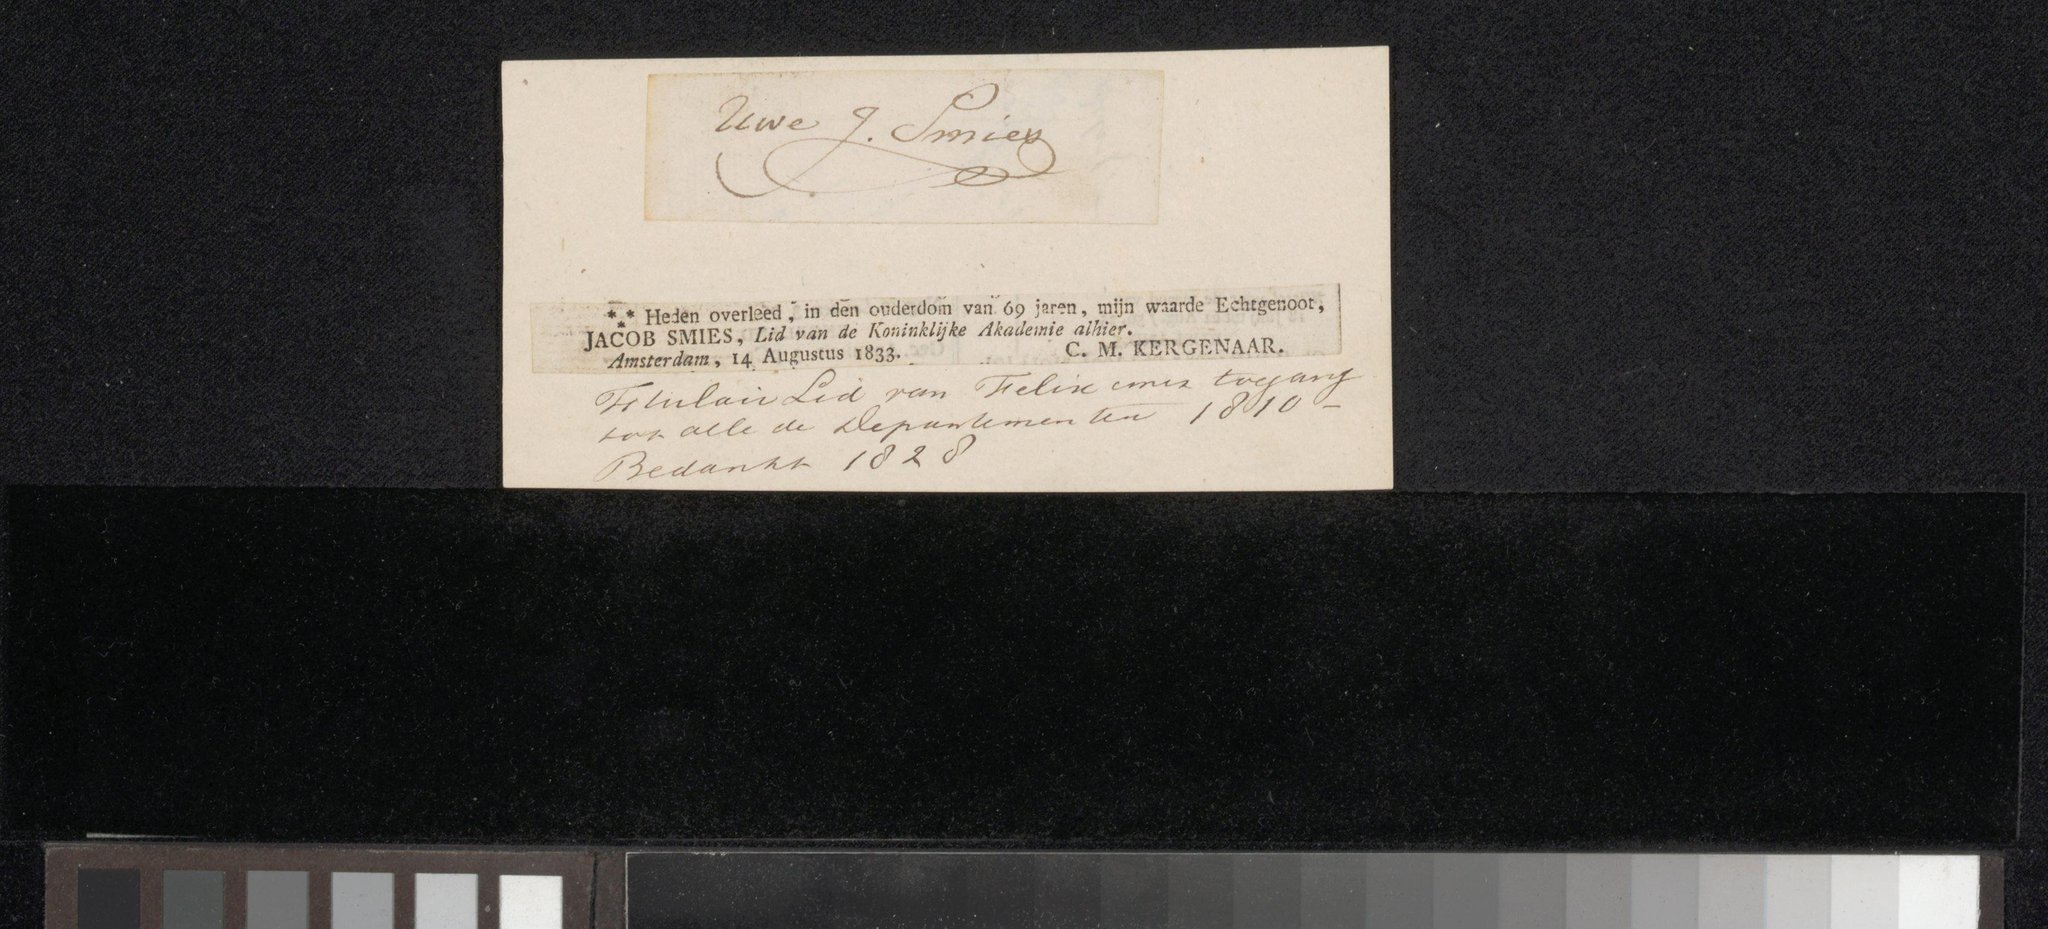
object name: manuscript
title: Handtekening van Jacob Smies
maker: jacob smies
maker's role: draughtsman, painter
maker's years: 1746-1833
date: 1756-1833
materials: ink, paper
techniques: pen, printing, writing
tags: amsterdam, painter, draughtsman, jacob smies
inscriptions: collector's mark: ‘RPK’